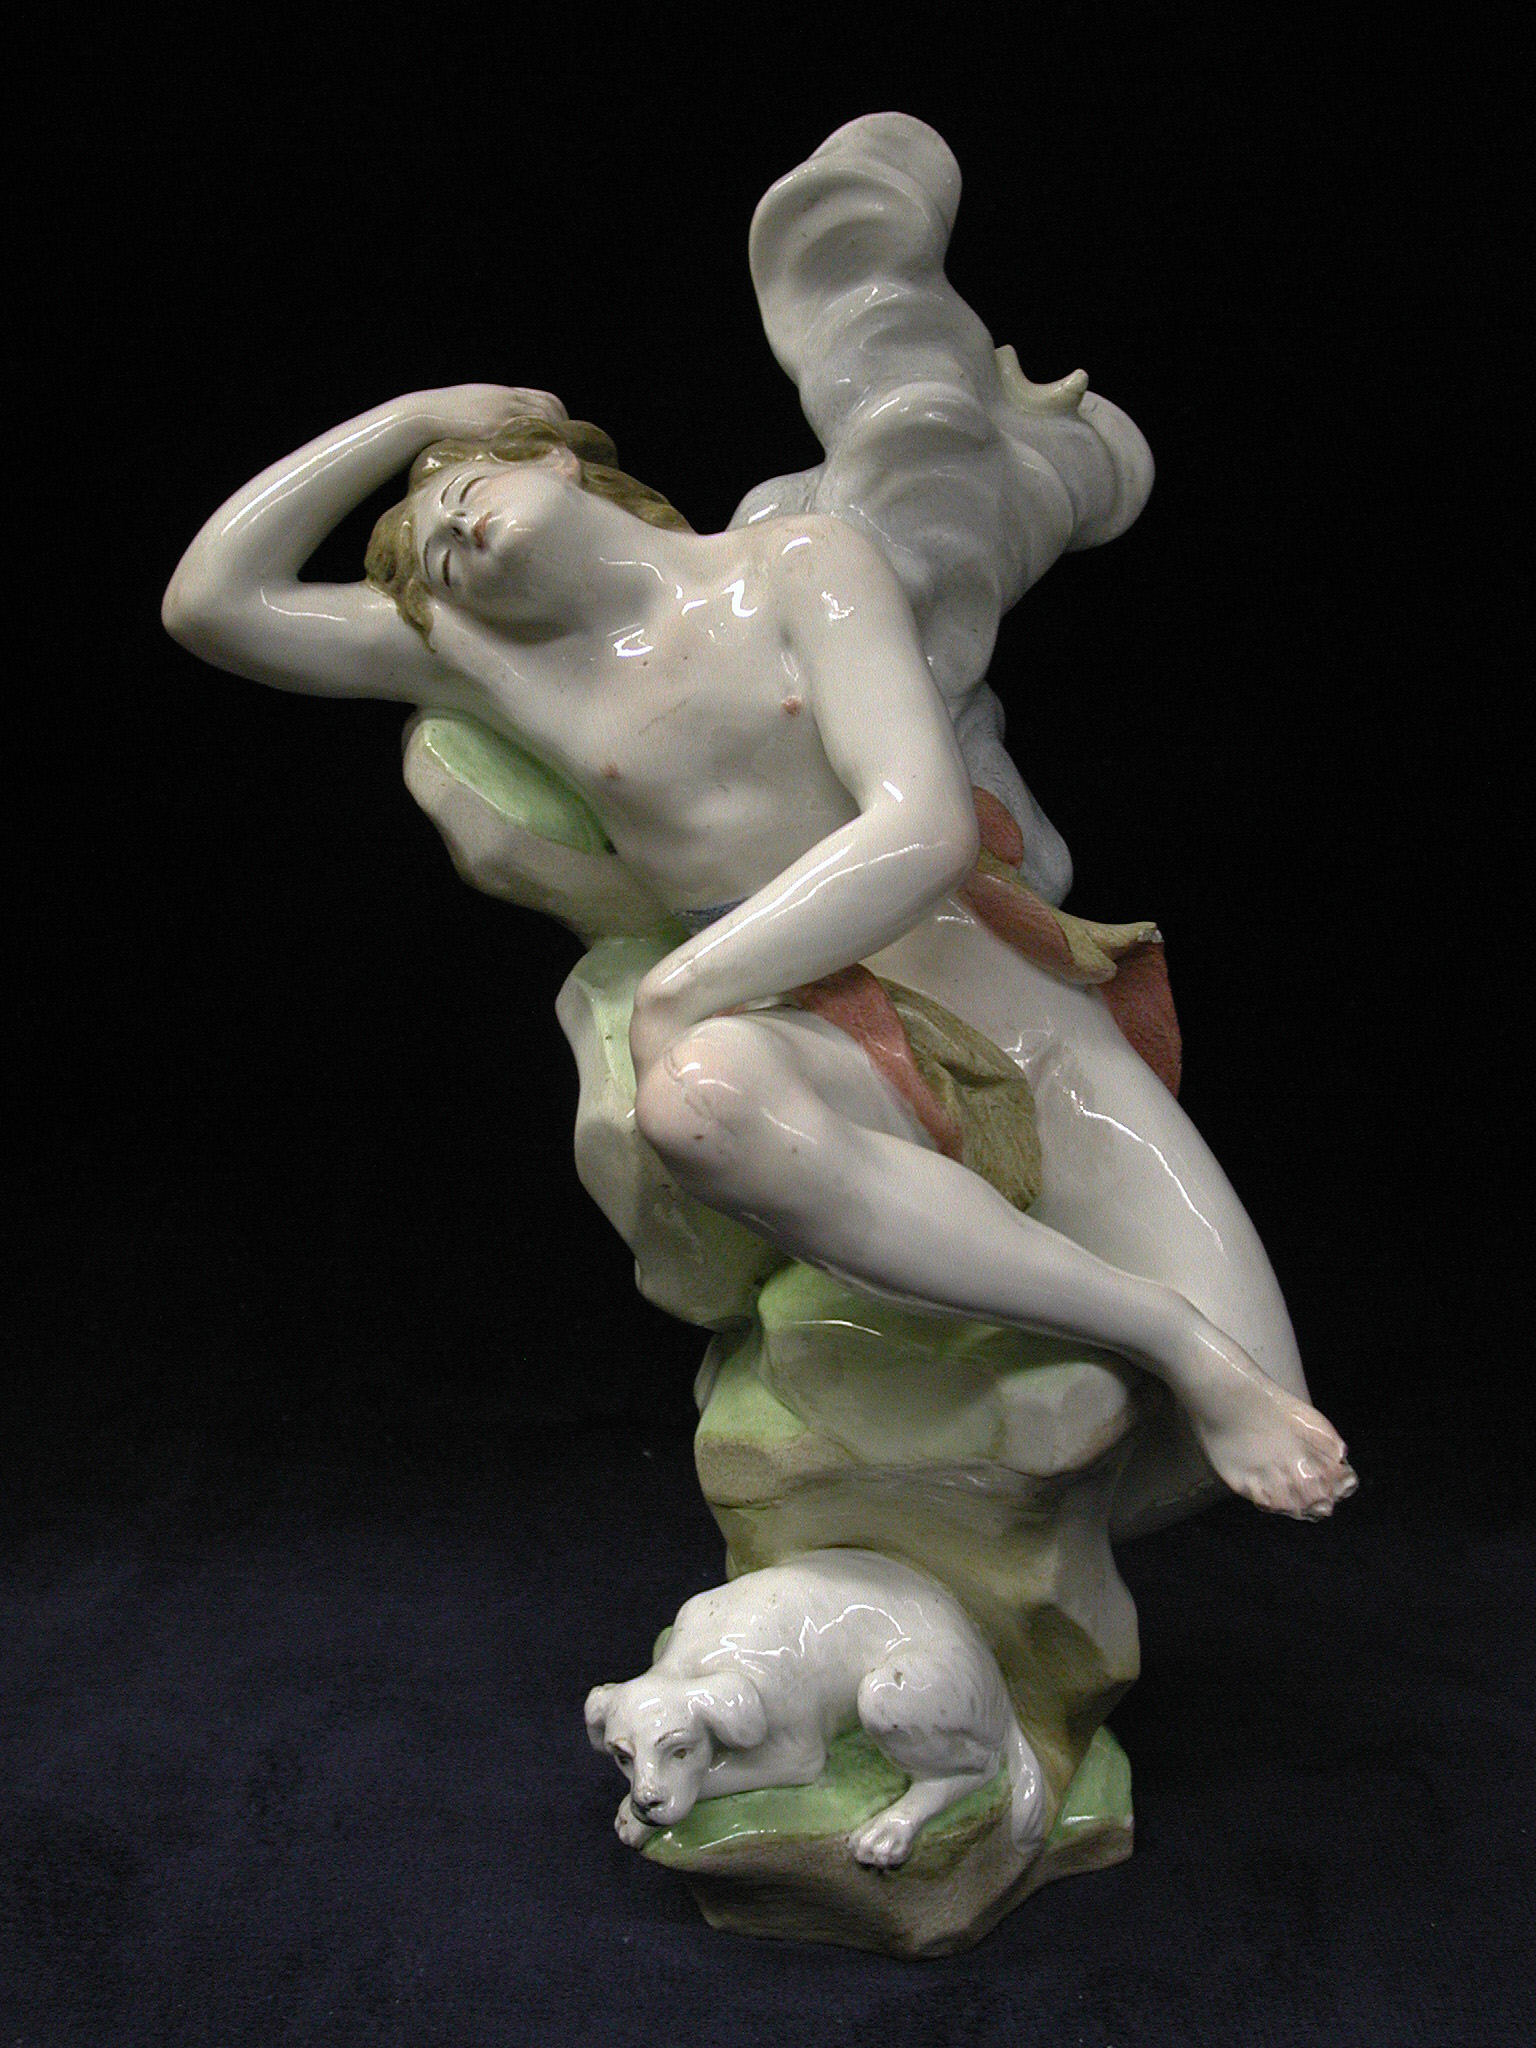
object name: figure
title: Endymion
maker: real fabrica de buen retiro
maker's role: factory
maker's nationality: spanish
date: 1760-1770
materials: soft paste porcelain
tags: sleeping,men,dogs